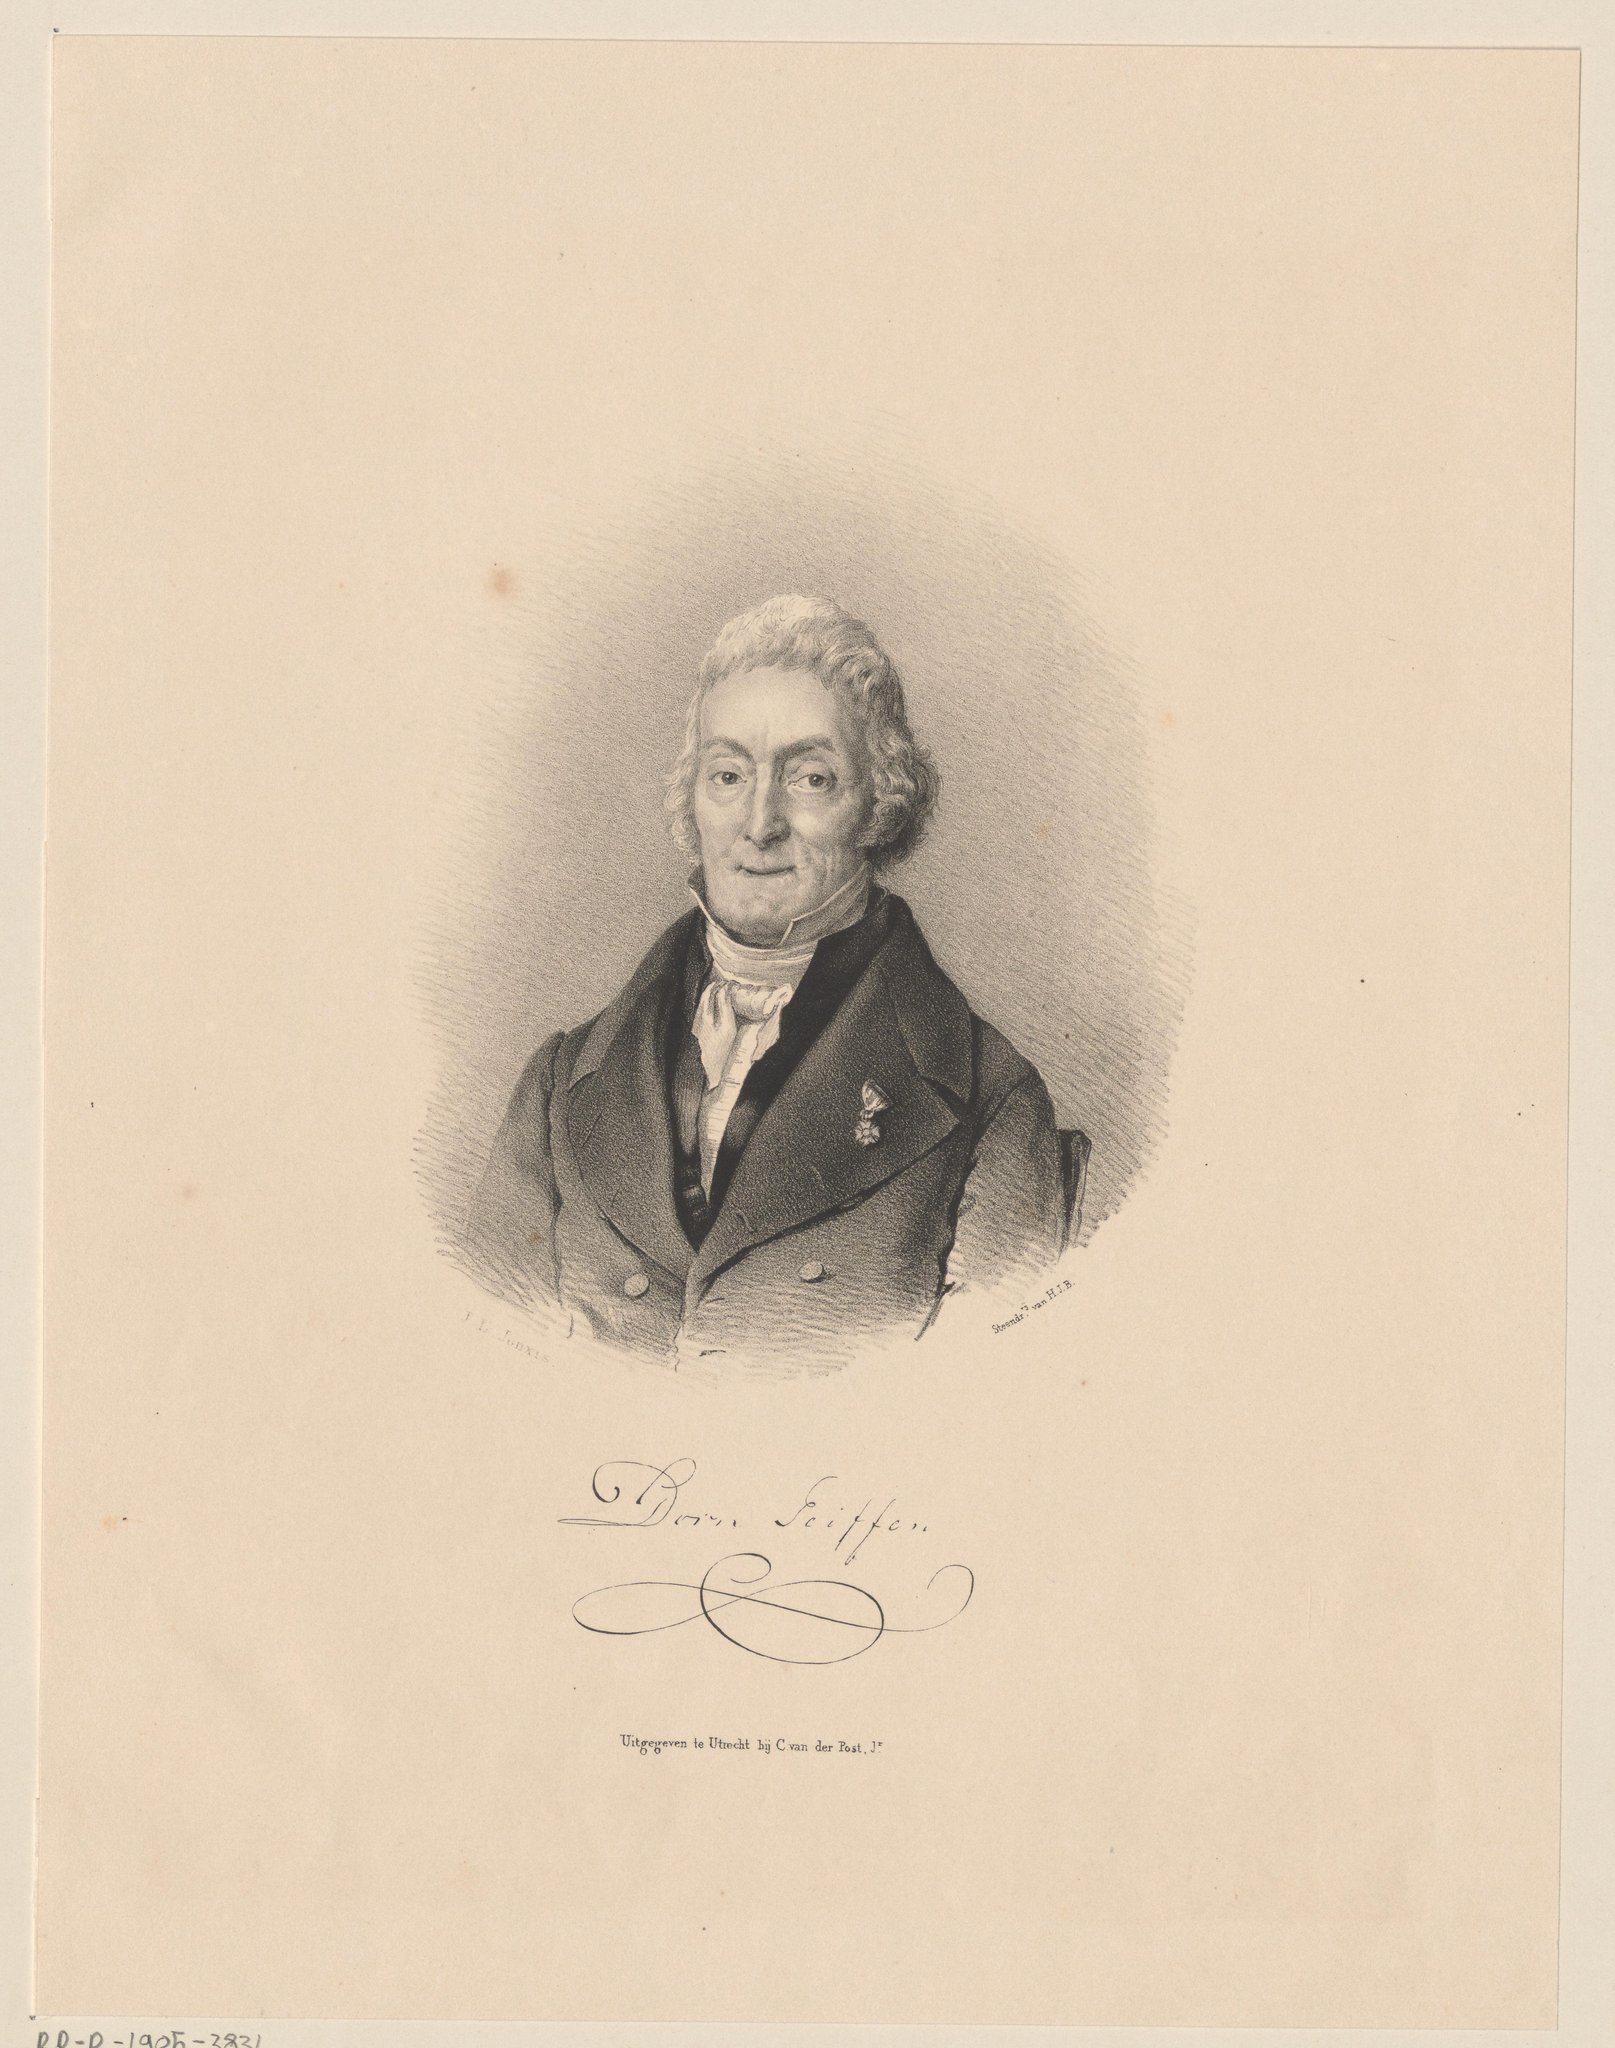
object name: print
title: Portret van Gerardus Dorn Seiffen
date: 1833-1845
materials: paper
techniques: lithograph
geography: dordrecht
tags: the hague, utrecht, gerardus dorn seiffen, further education, historical persons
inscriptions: collector's mark: Lugt 2228